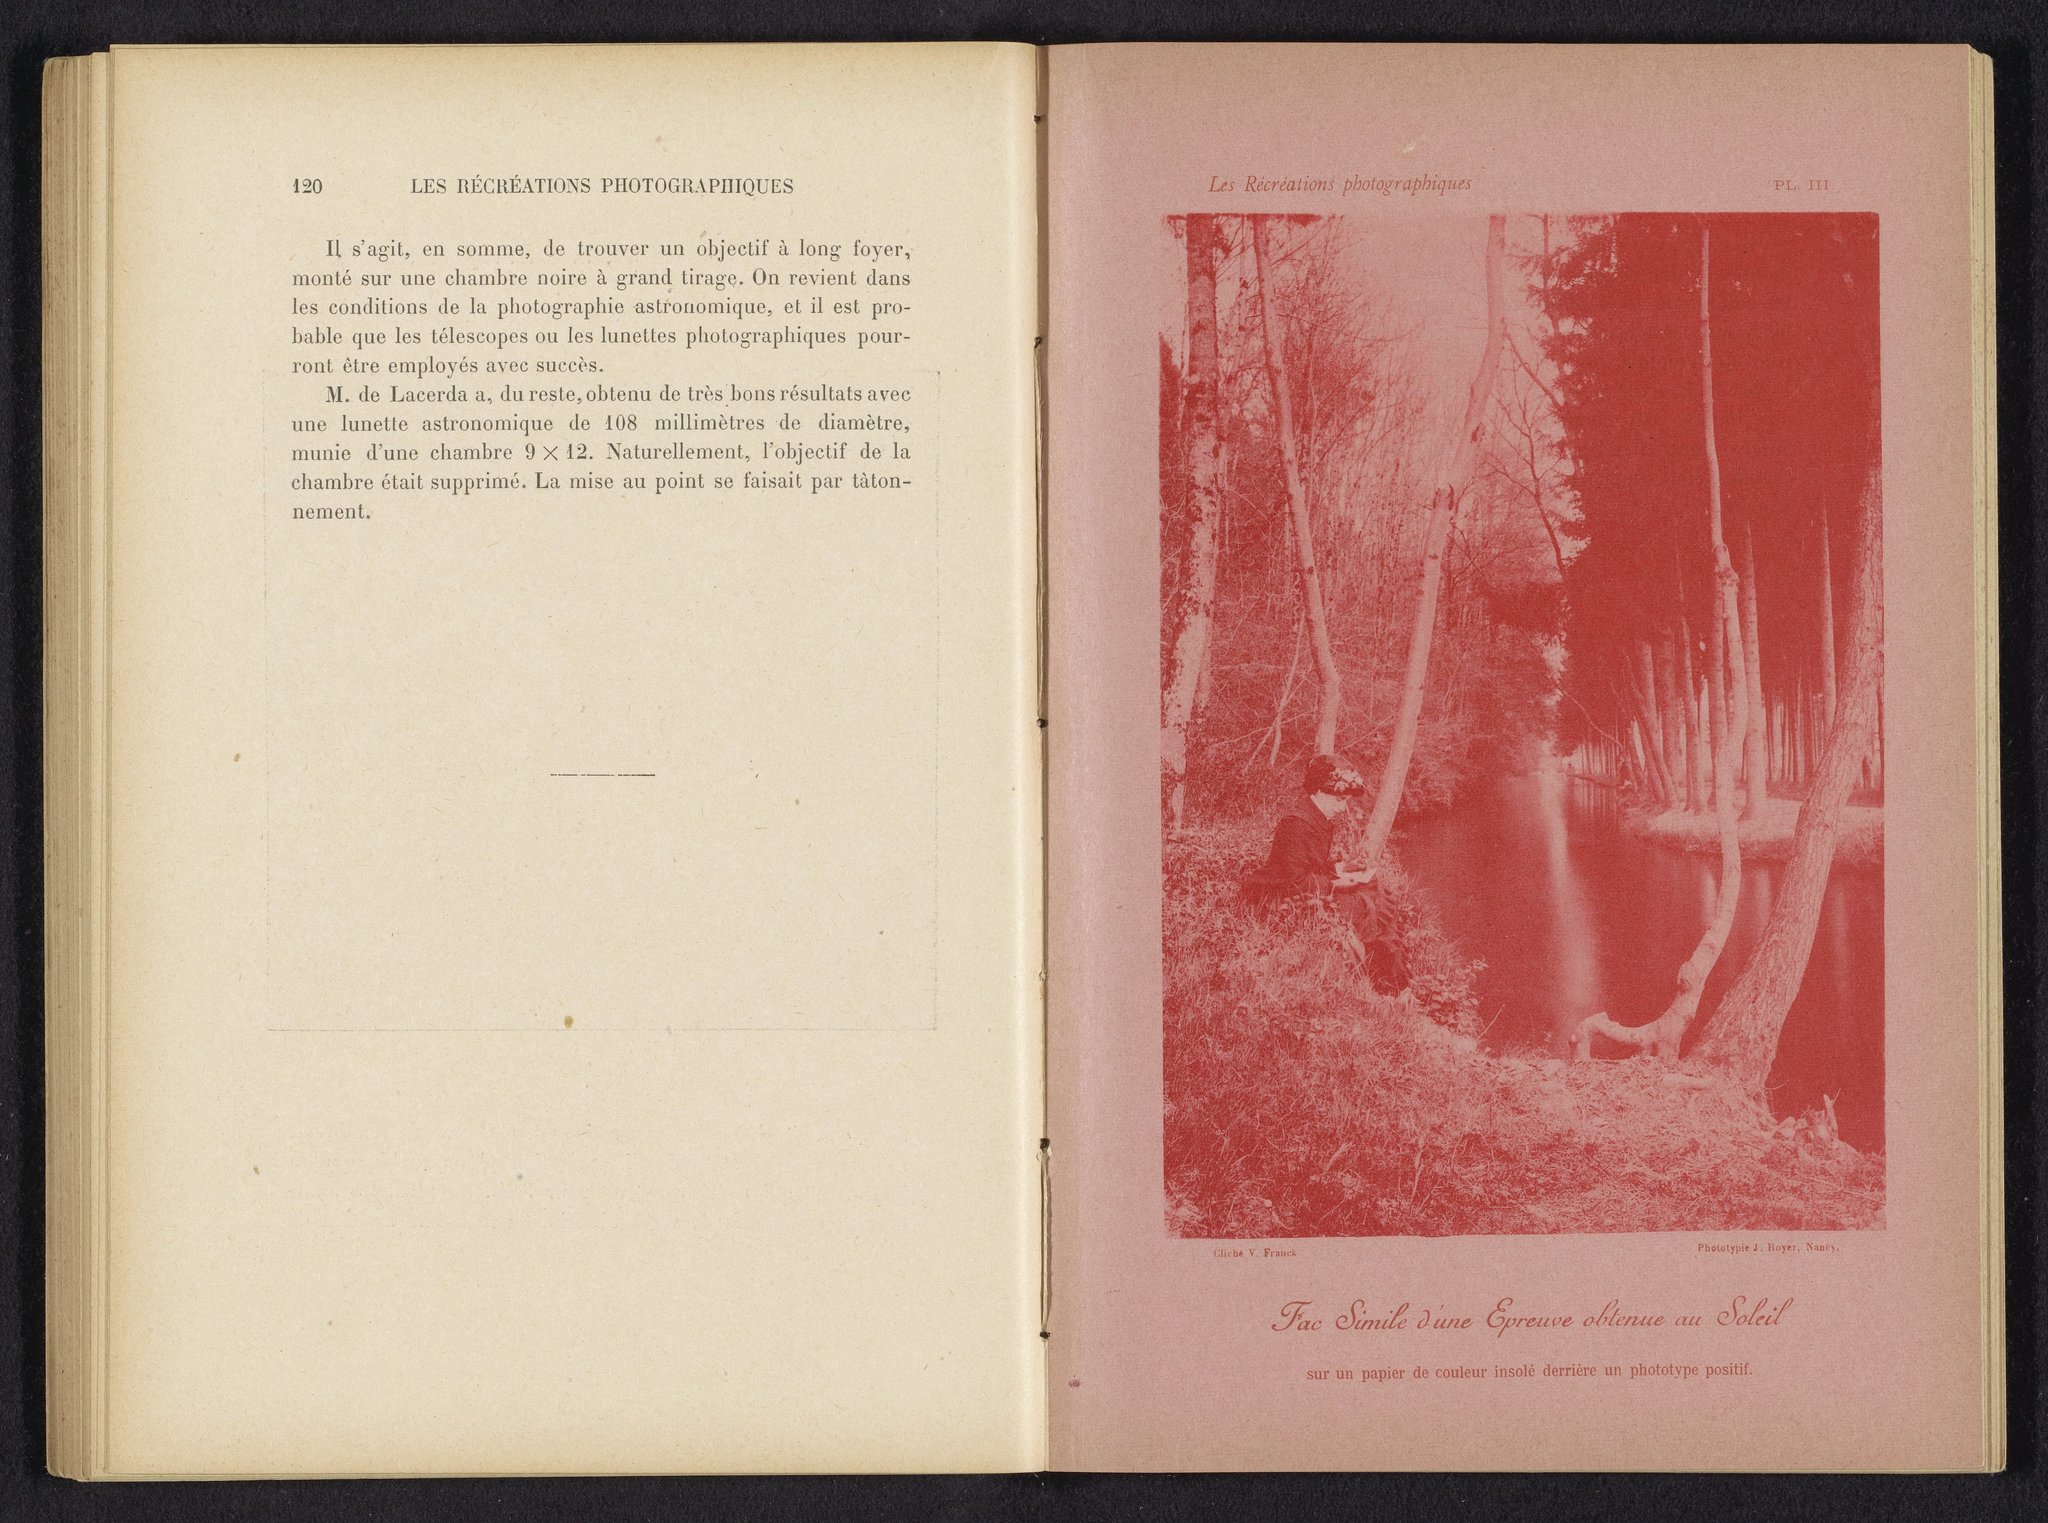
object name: page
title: Zittende vrouw op een waterkant met bomen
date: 1883-1893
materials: paper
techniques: photograph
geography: nancy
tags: water course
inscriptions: number: ‘Pl. III’, inscription: ‘sur un papier de couleur insolé derrière un phototype positif.’